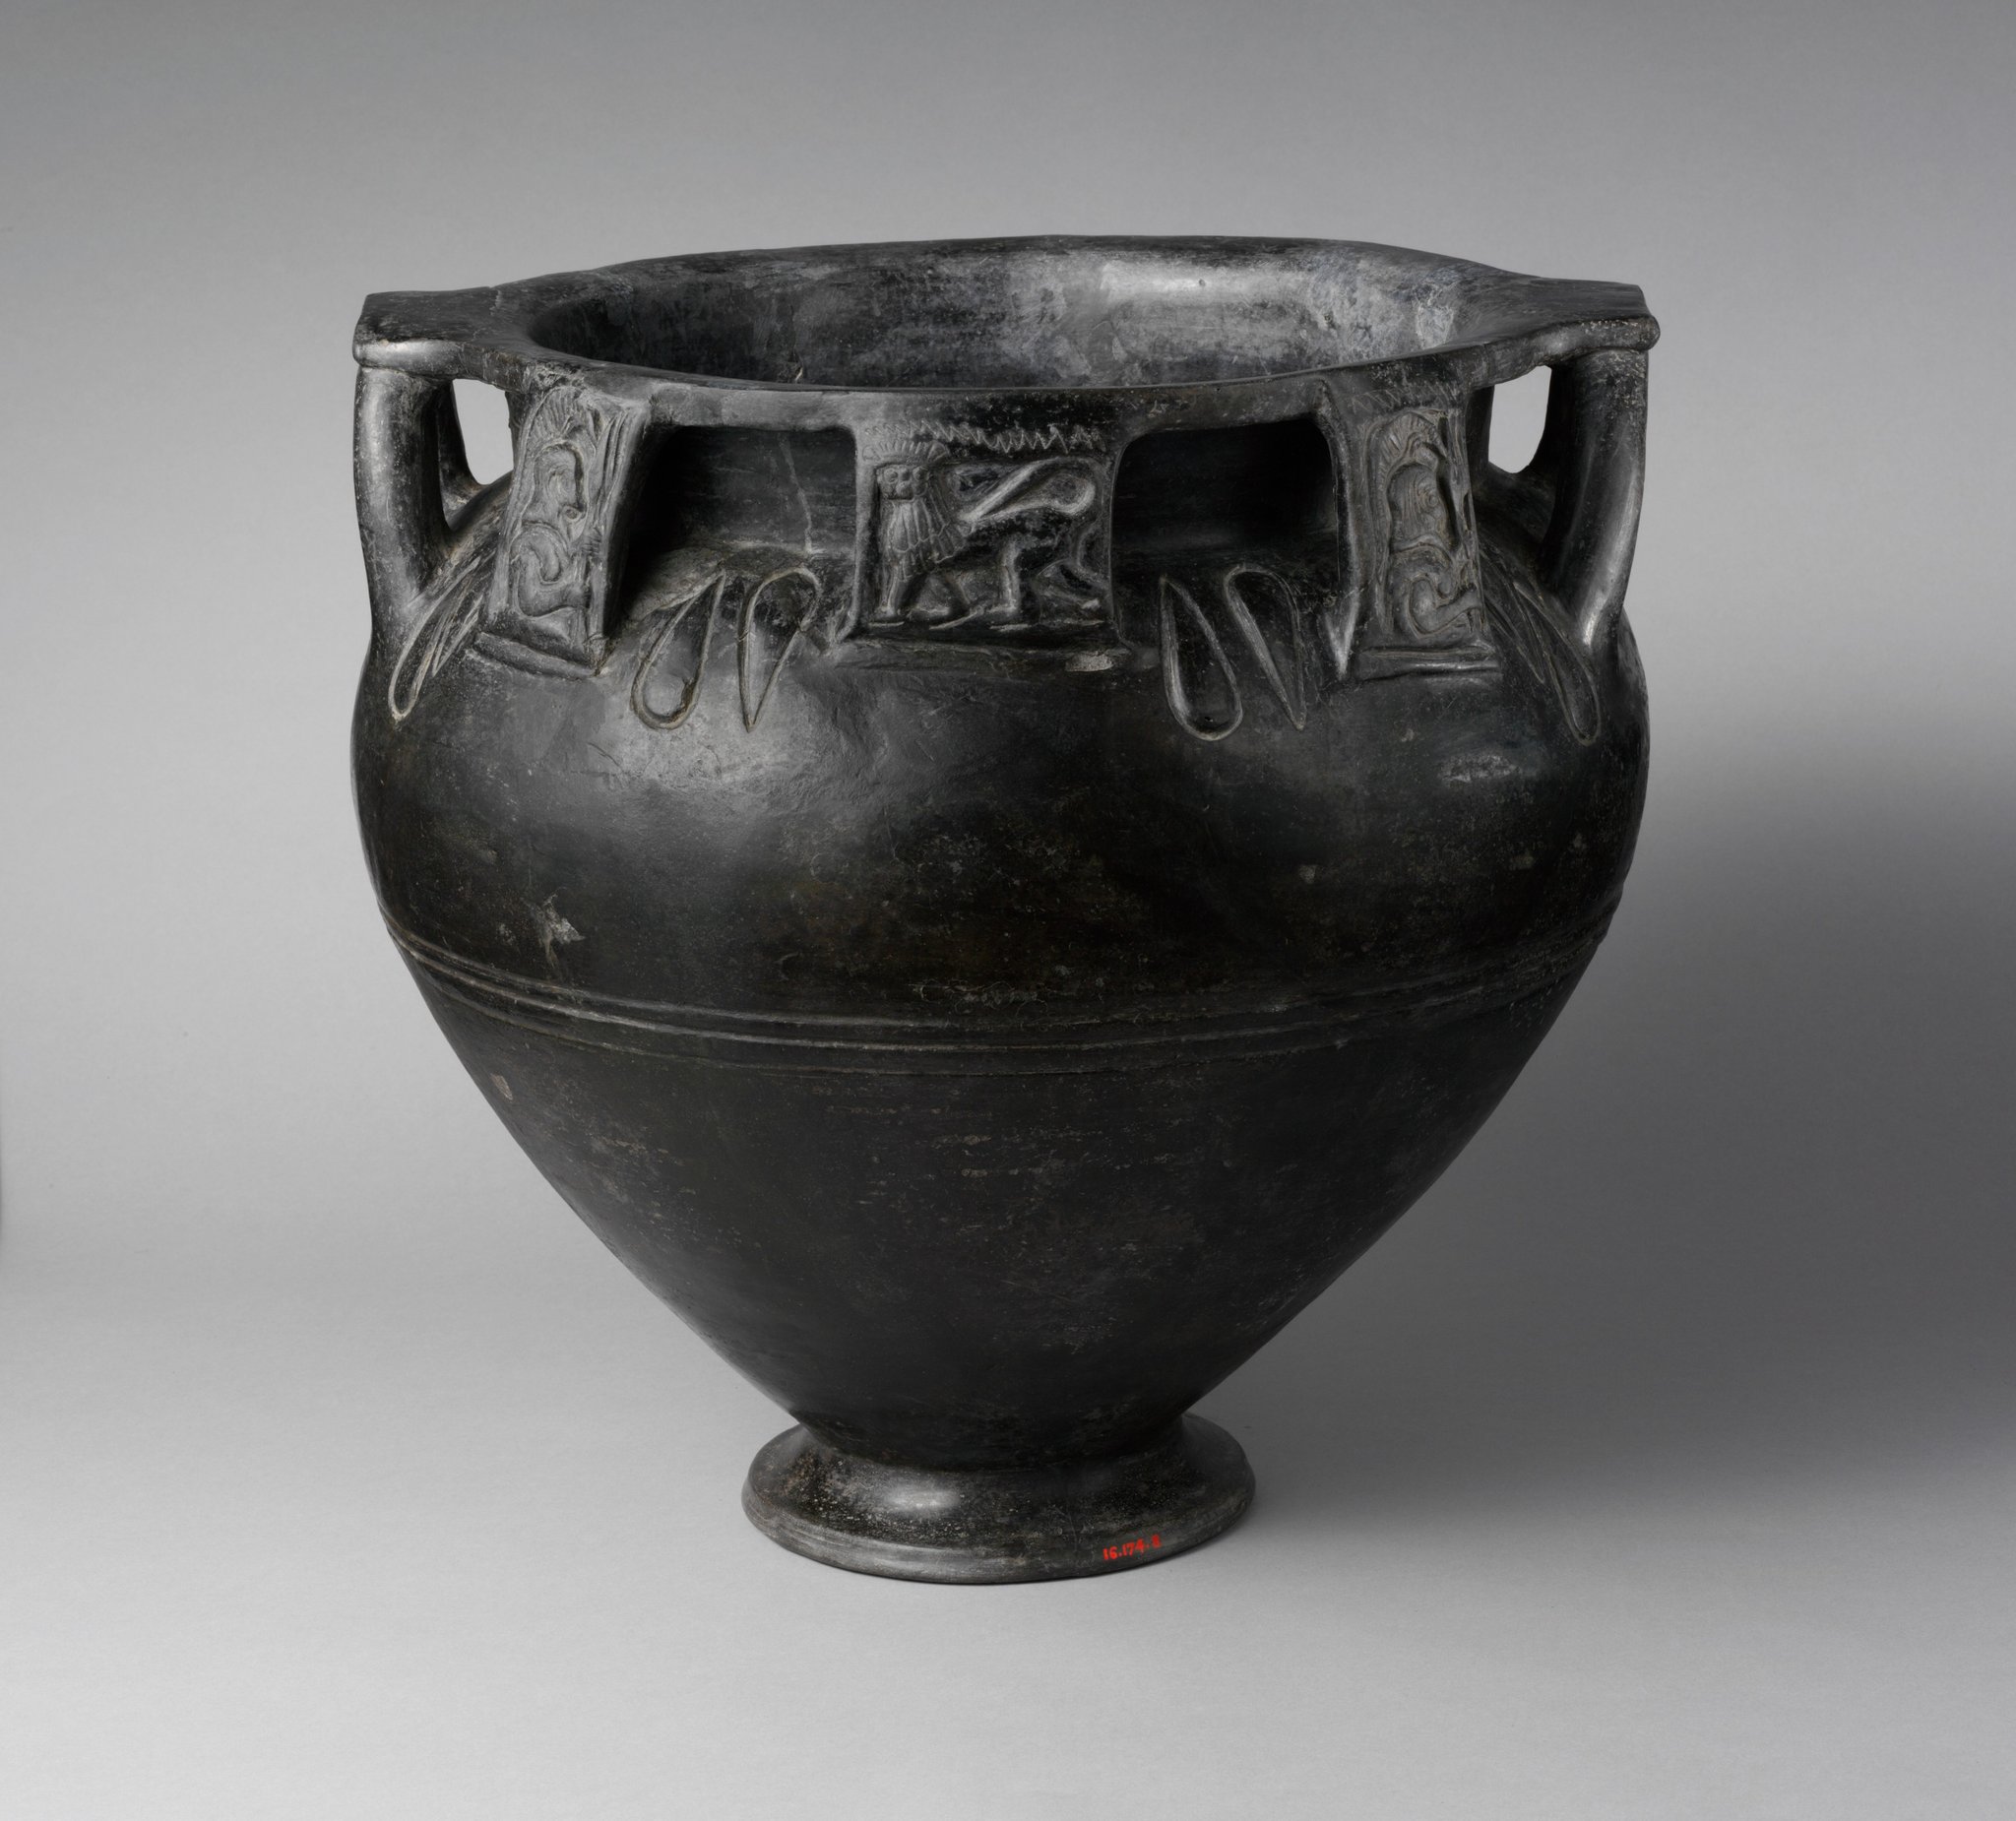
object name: column krater with panel relief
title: Terracotta column-krater (bowl for mixing wine and water)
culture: etruscan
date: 560-500 BCE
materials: terracotta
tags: lions,warriors